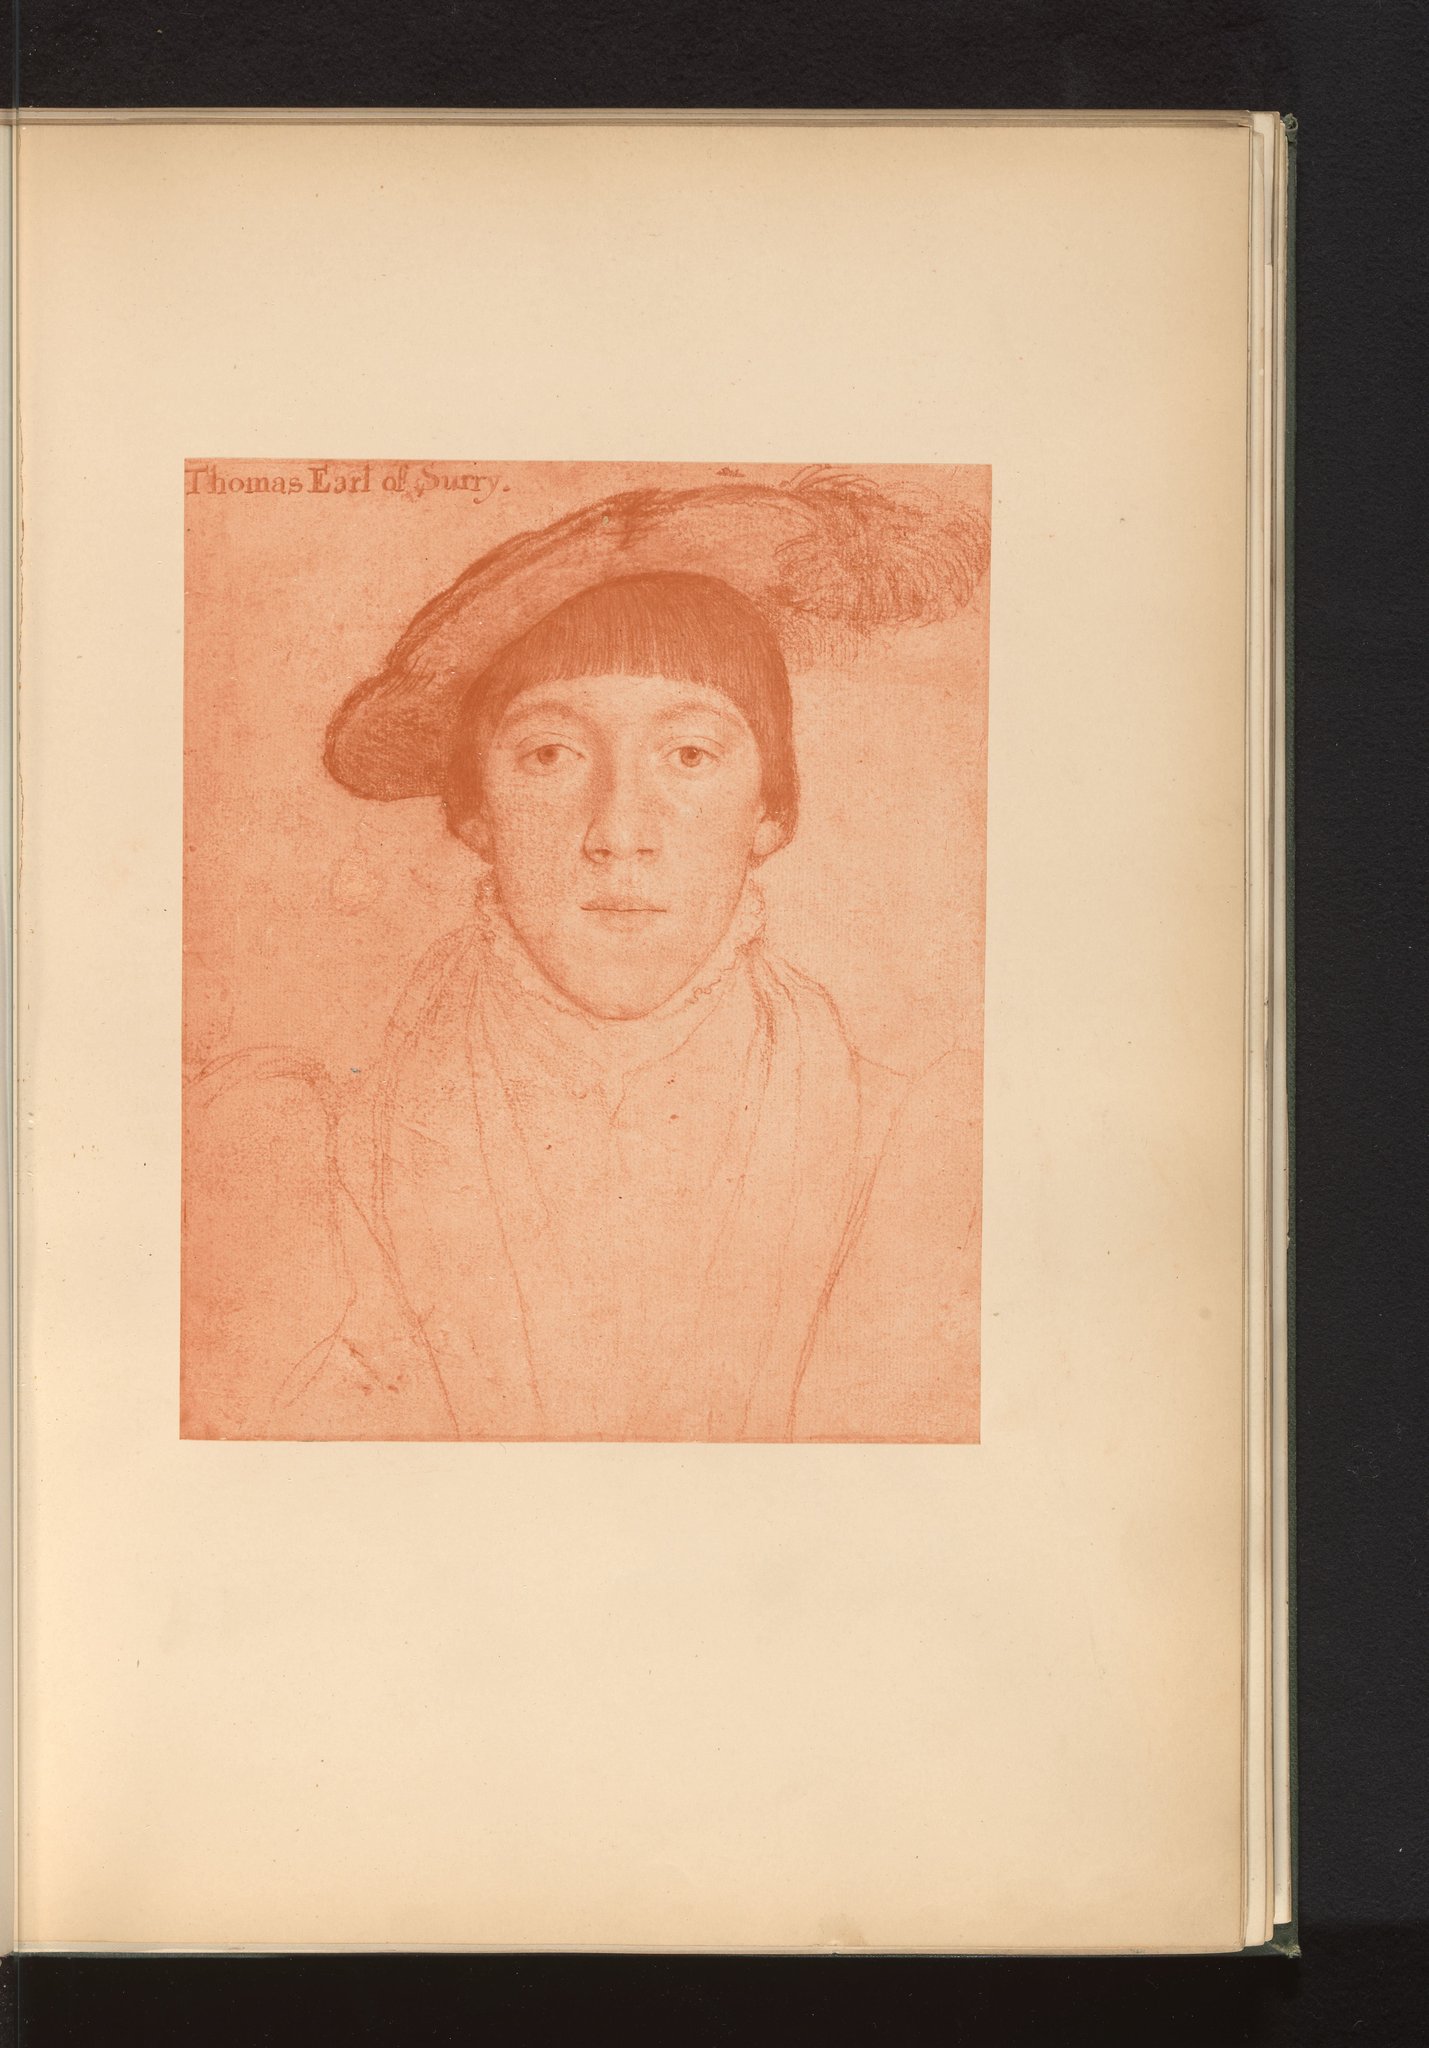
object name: page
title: Fotoreproductie van een portret van Thomas Howard, hertog van Norfolk, door Hans Holbein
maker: Anonymous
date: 1872-1877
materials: paper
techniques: carbon print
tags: london, drawing, sketch, historical persons